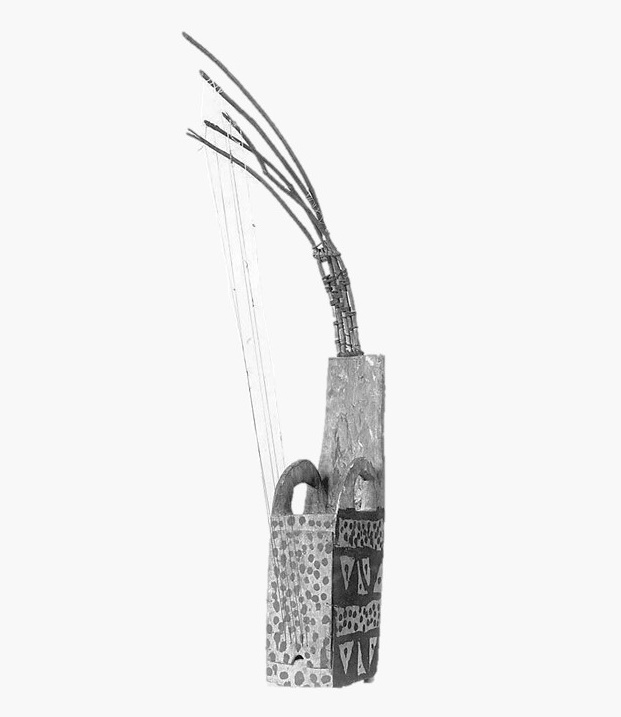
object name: angra oowena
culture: baganda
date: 1867-1900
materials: wood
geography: uganda